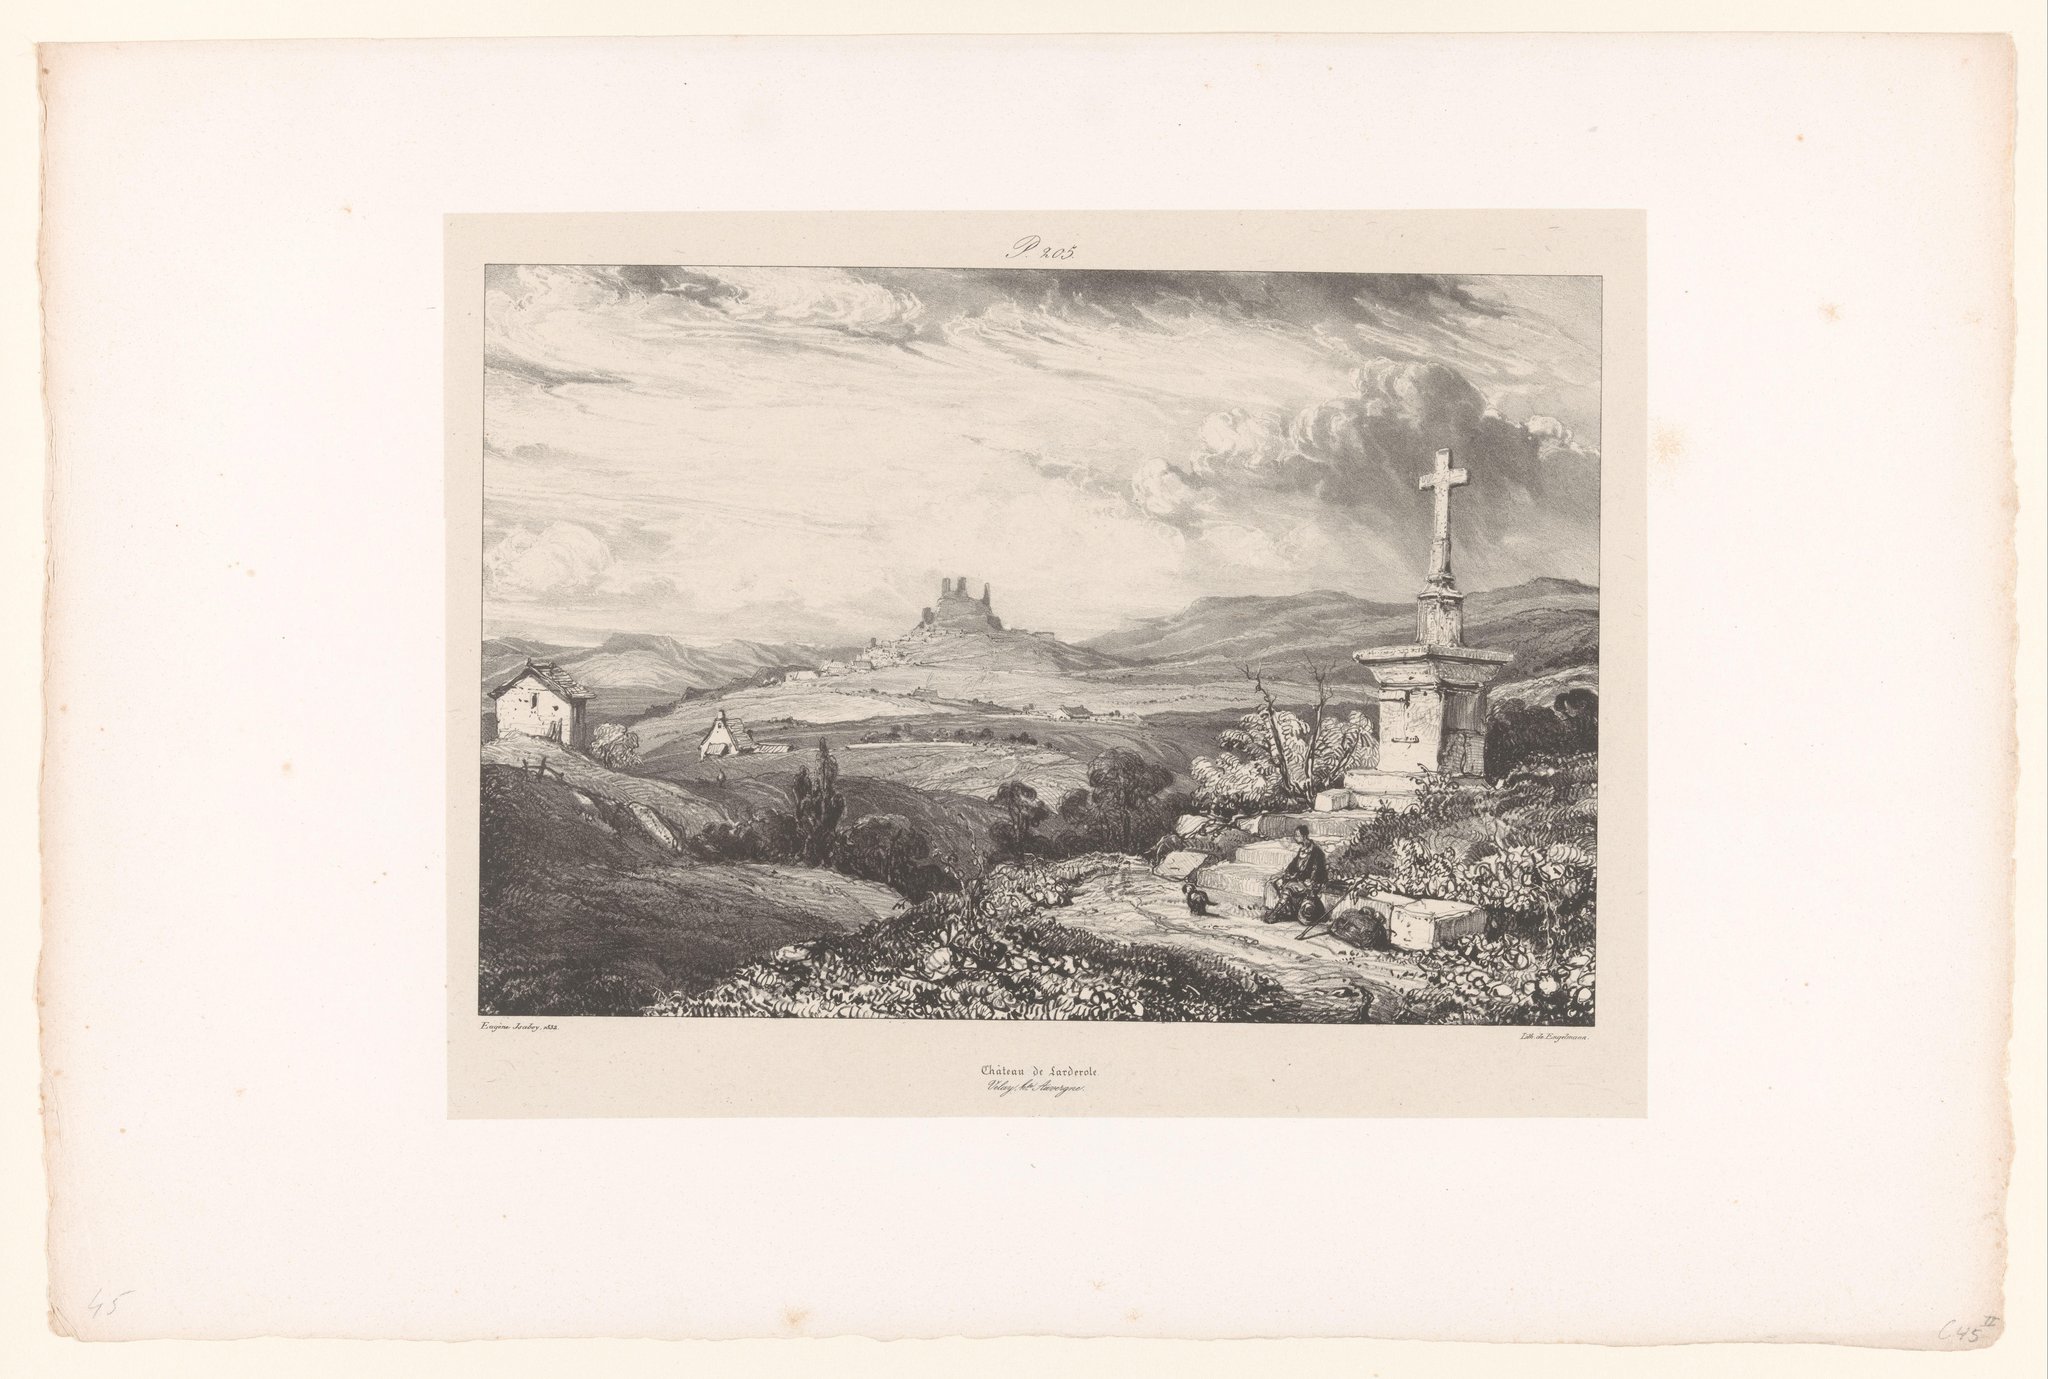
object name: print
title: Pittoreske reizen door het Frankrijk van weleer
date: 1832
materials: paper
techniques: lithograph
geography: paris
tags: (traveller) resting in the open air, landscape with tower or castle, road-cross, 'mont-joie', (high) hill (+ landscape with figures, staffage)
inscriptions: collector's mark: Lugt 2228a, collector's mark: Lugt 2760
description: Prent gebruikt voor: Nodier, Ch. en Taylor, I. Voyages pittoresques et romantiques dans l'ancienne France. Auvergne. Parijs: Casimir Gide, 1829-1833. dl. 1, p. 205.